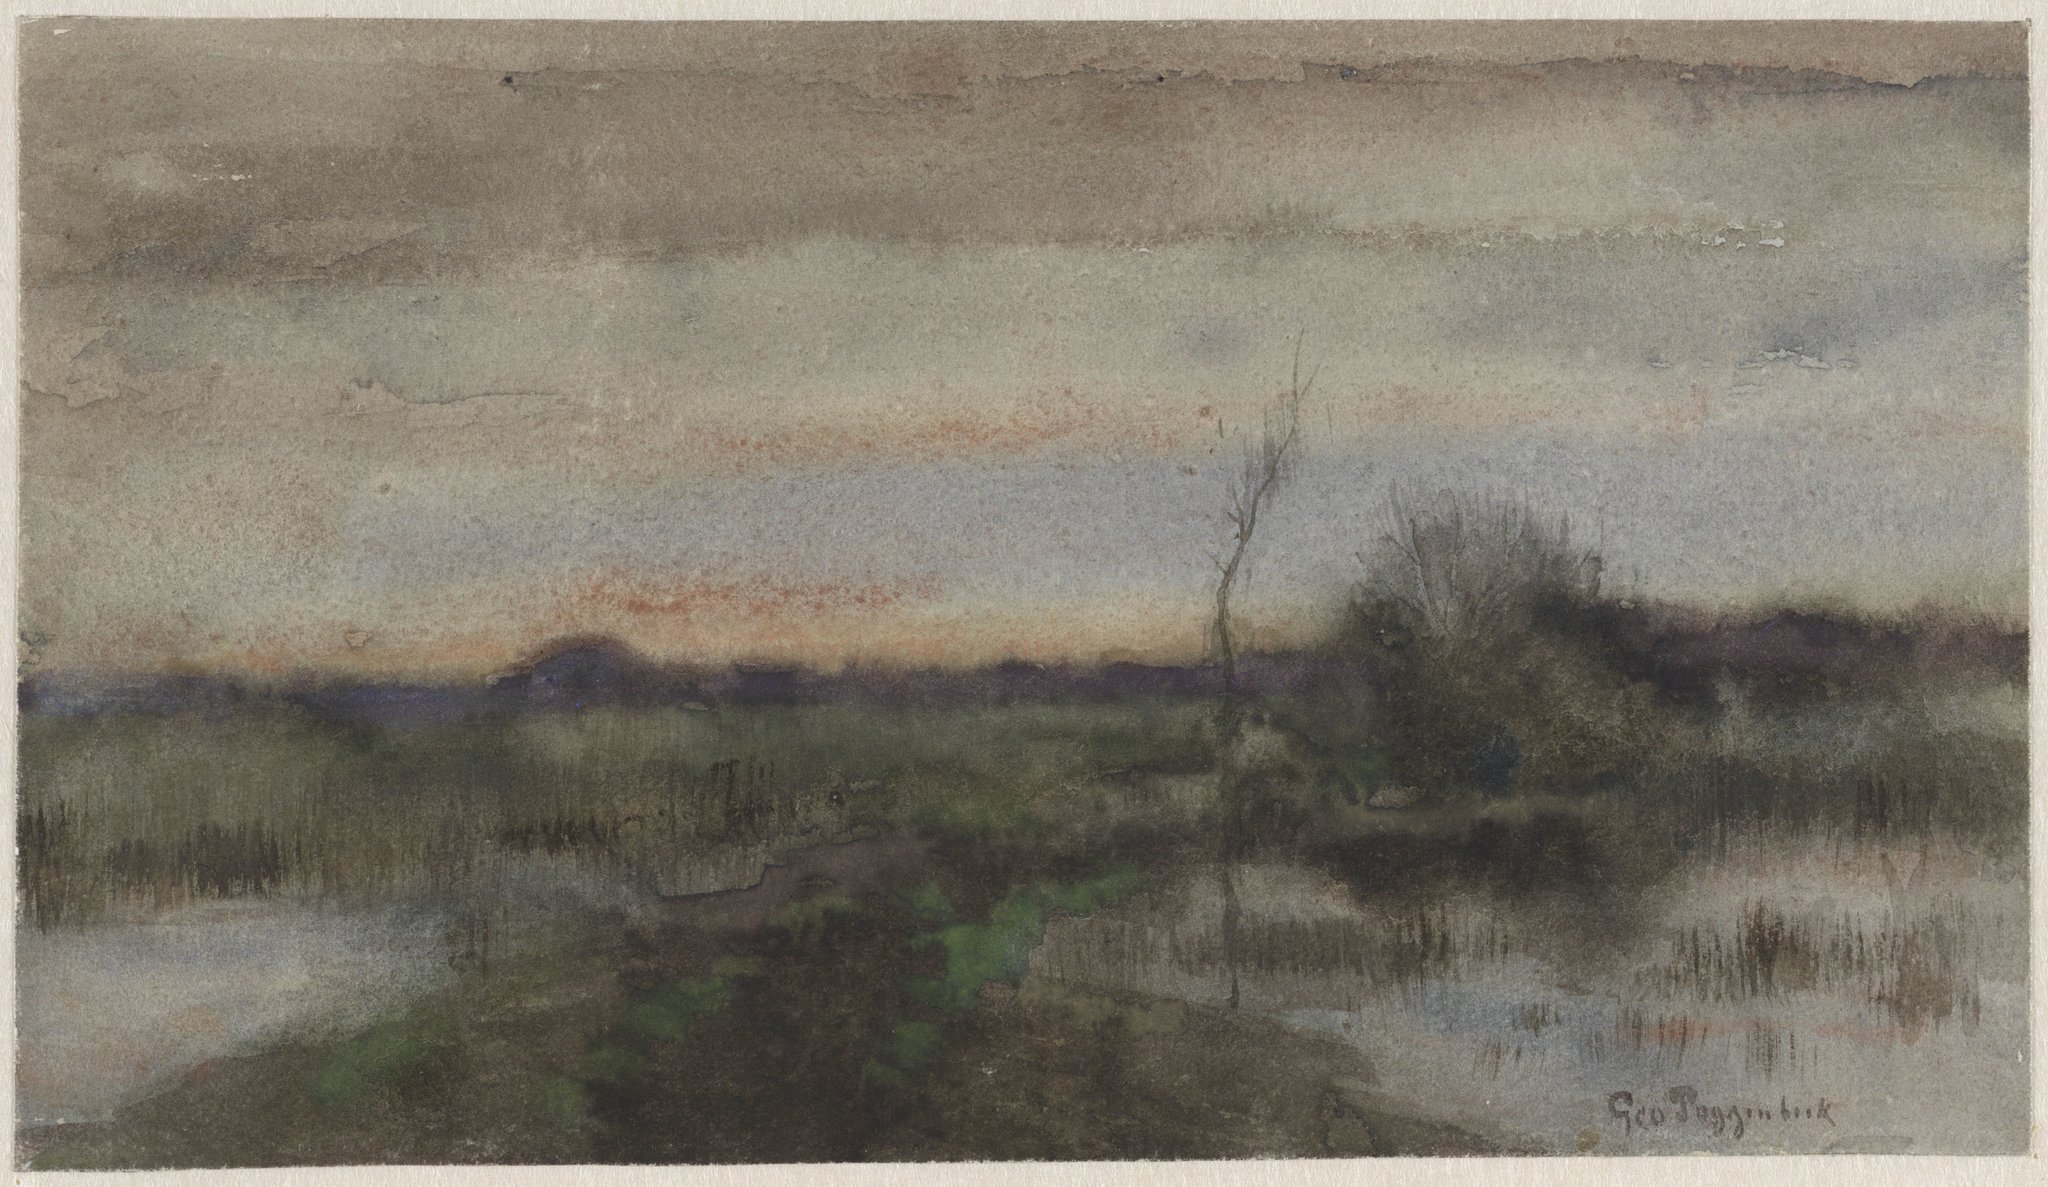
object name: drawing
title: Moeraslandschap met zonsondergang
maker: geo poggenbeek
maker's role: draughtsman, painter, print maker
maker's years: 1853-1903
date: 1863-1903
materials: paper, watercolor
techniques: brush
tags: swamp, inland marsh, fens